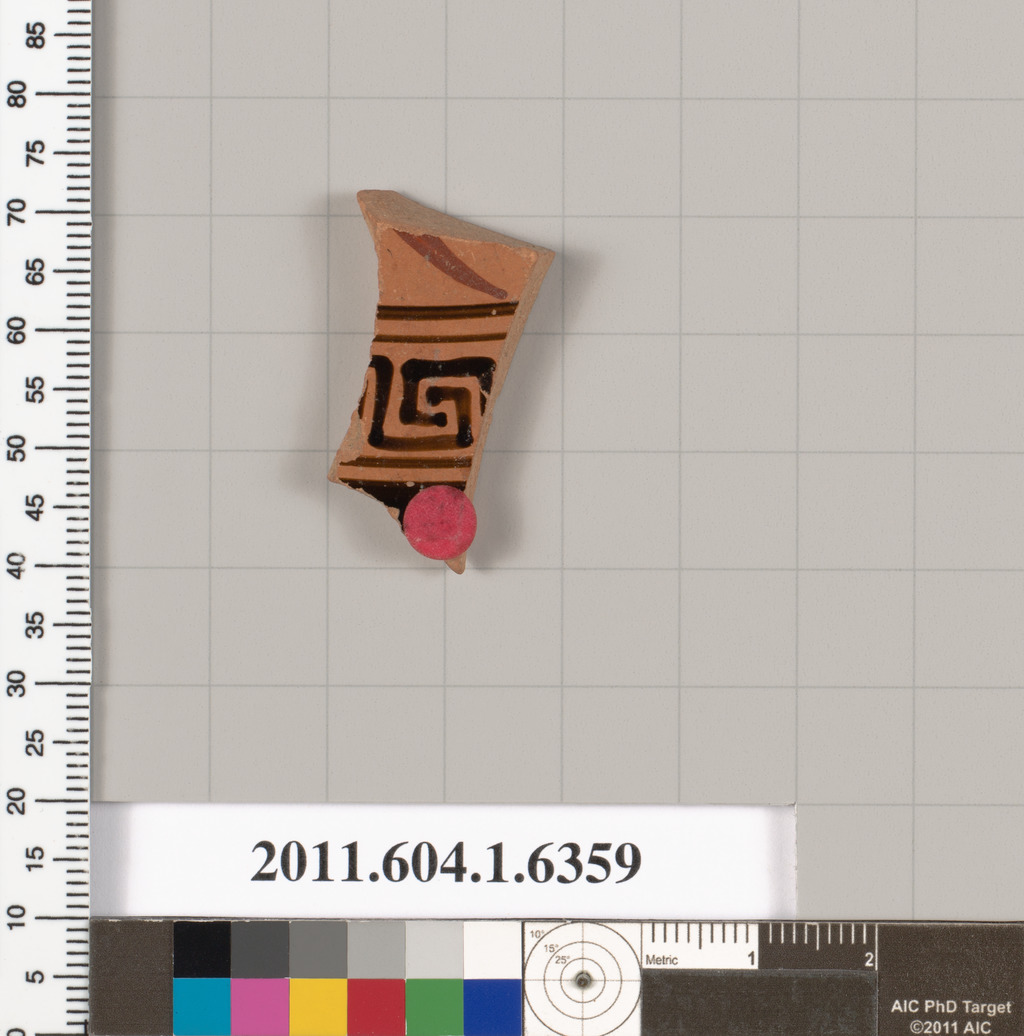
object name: kylix fragment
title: Terracotta fragment of a kylix (drinking cup)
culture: greek, attic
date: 500-480 BCE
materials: terracotta